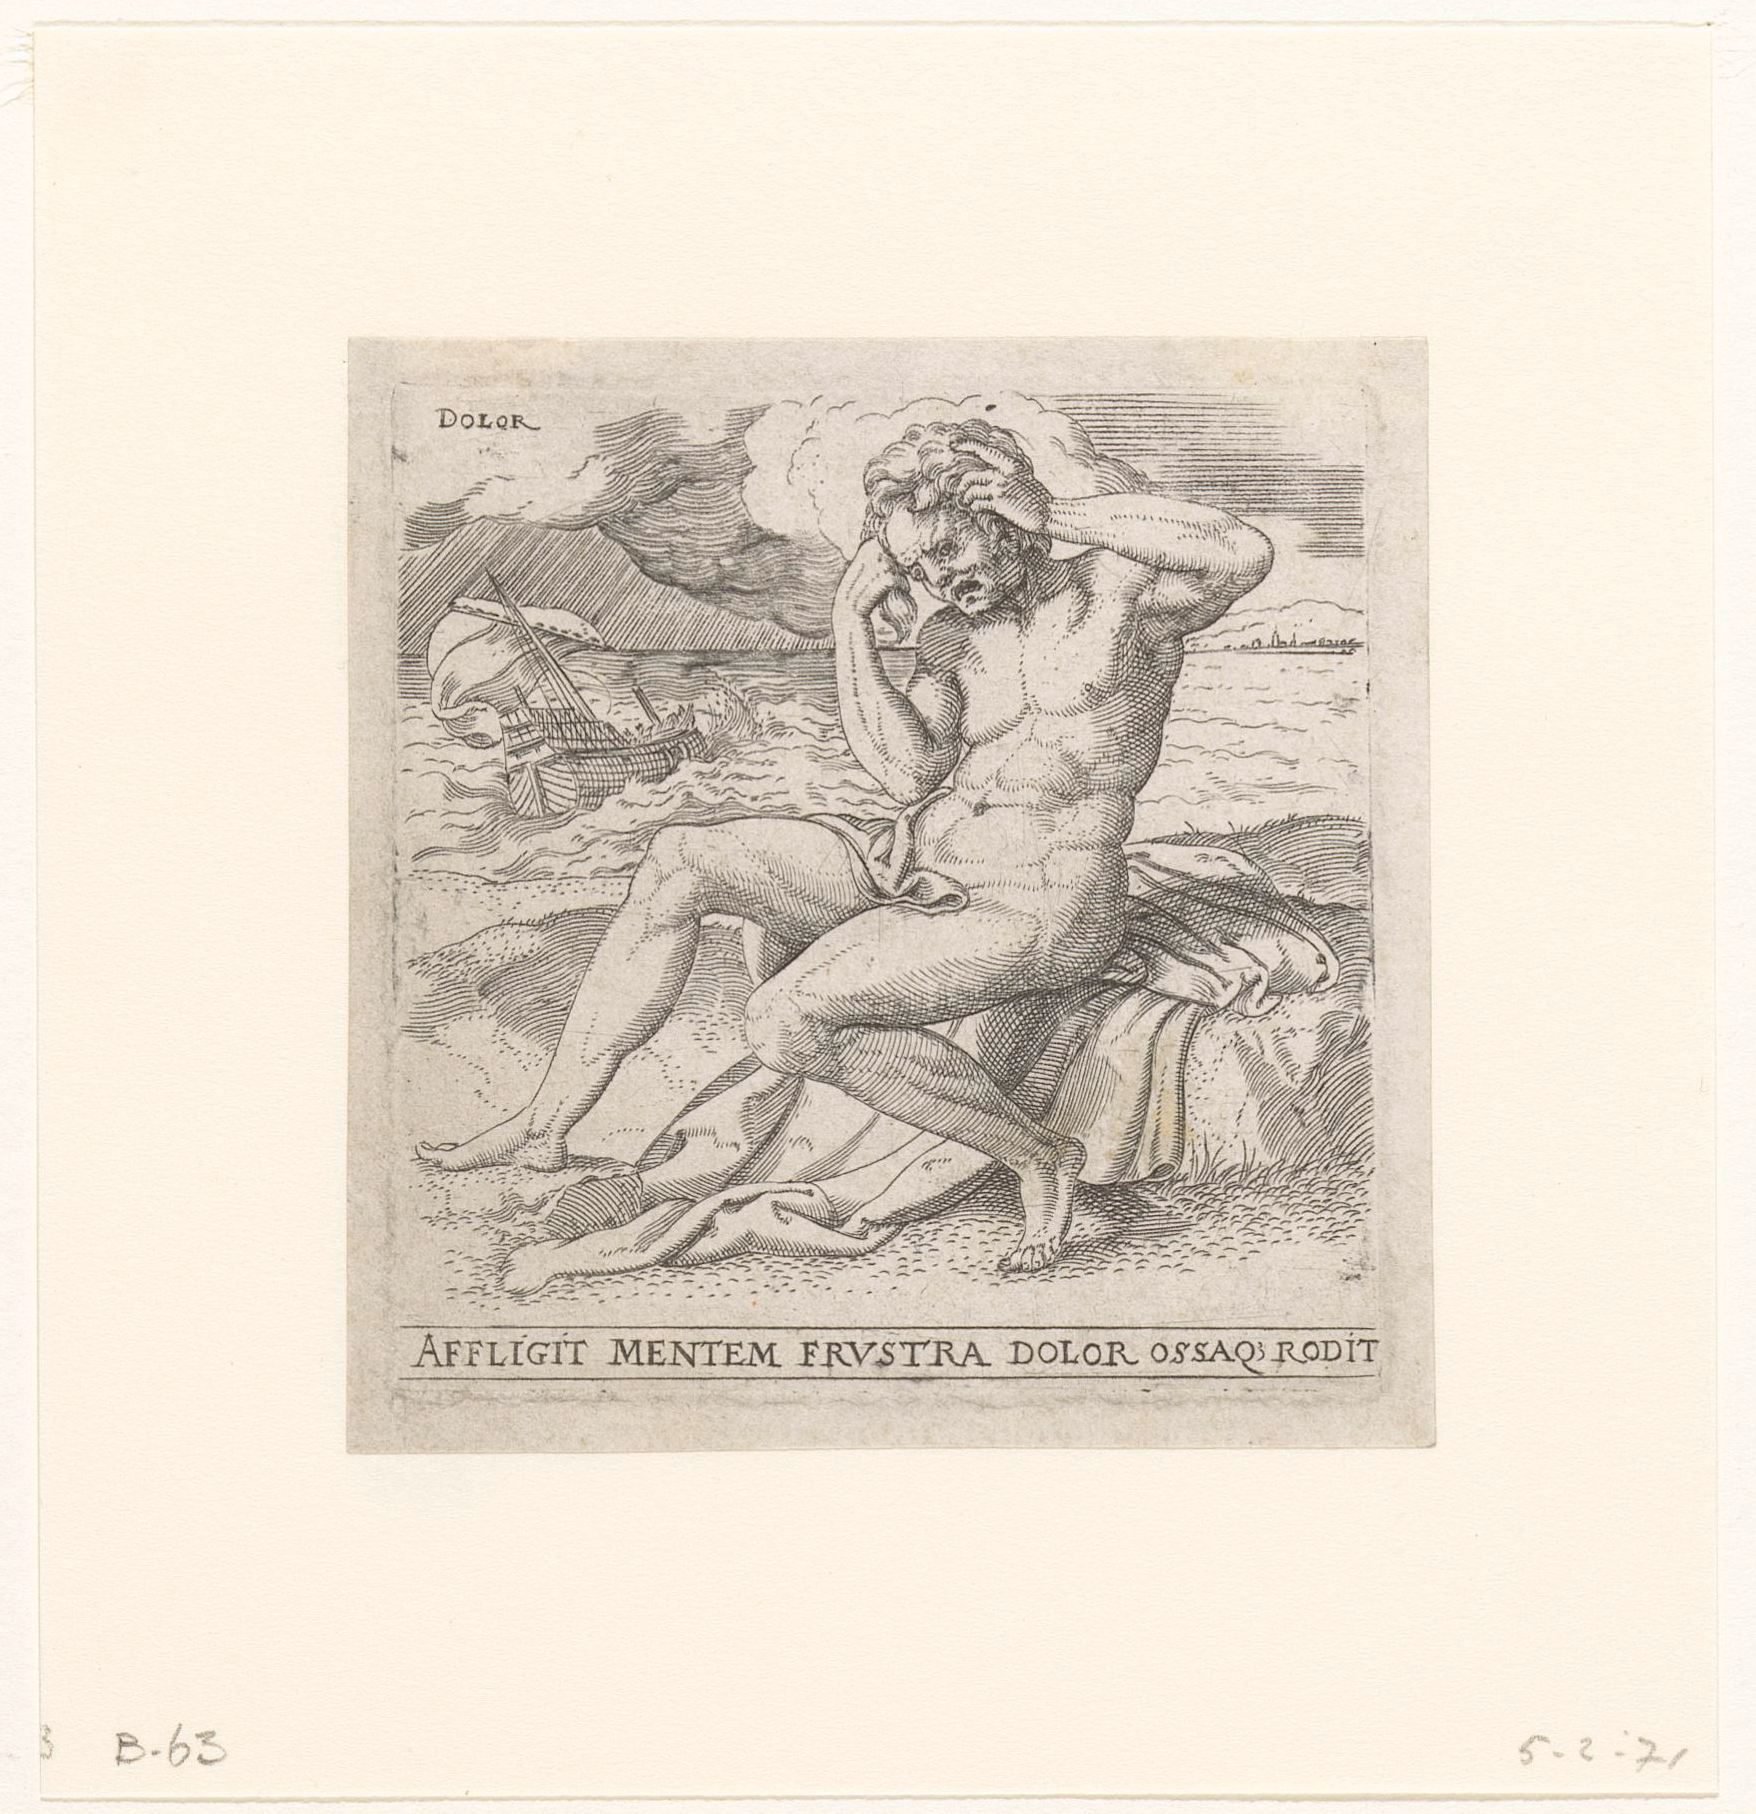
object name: print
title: Emblematische figuren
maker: francesco salviati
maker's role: draughtsman, painter, print maker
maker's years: 1510-1563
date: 1533-1567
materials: paper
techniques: engraving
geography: italy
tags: pain, sorrow, sadness; 'dolore', 'dolore di zeusi' (ripa)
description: Smart (Dolor) als zittende naakte man, trekkend aan zijn haren. Op de achtergrond een schip dat geteisterd wordt door een storm. Regel Latijnse tekst in ondermarge.